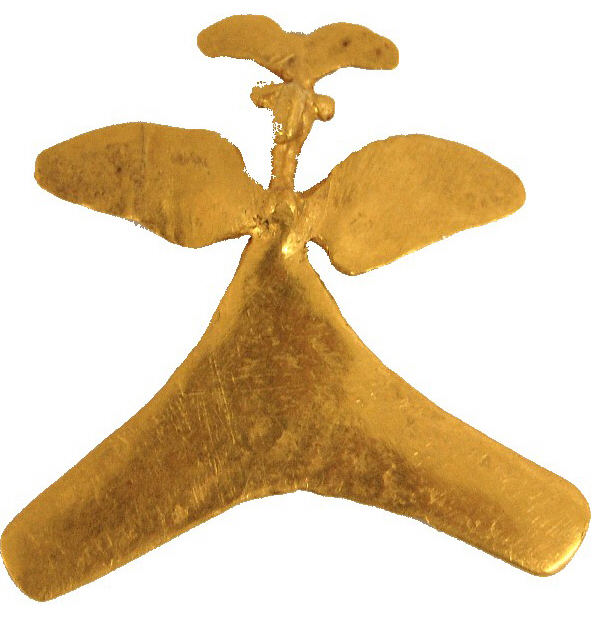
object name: pendant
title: Eagle Pendant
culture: veraguas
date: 1001-1600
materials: gold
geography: costa rica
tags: eagles